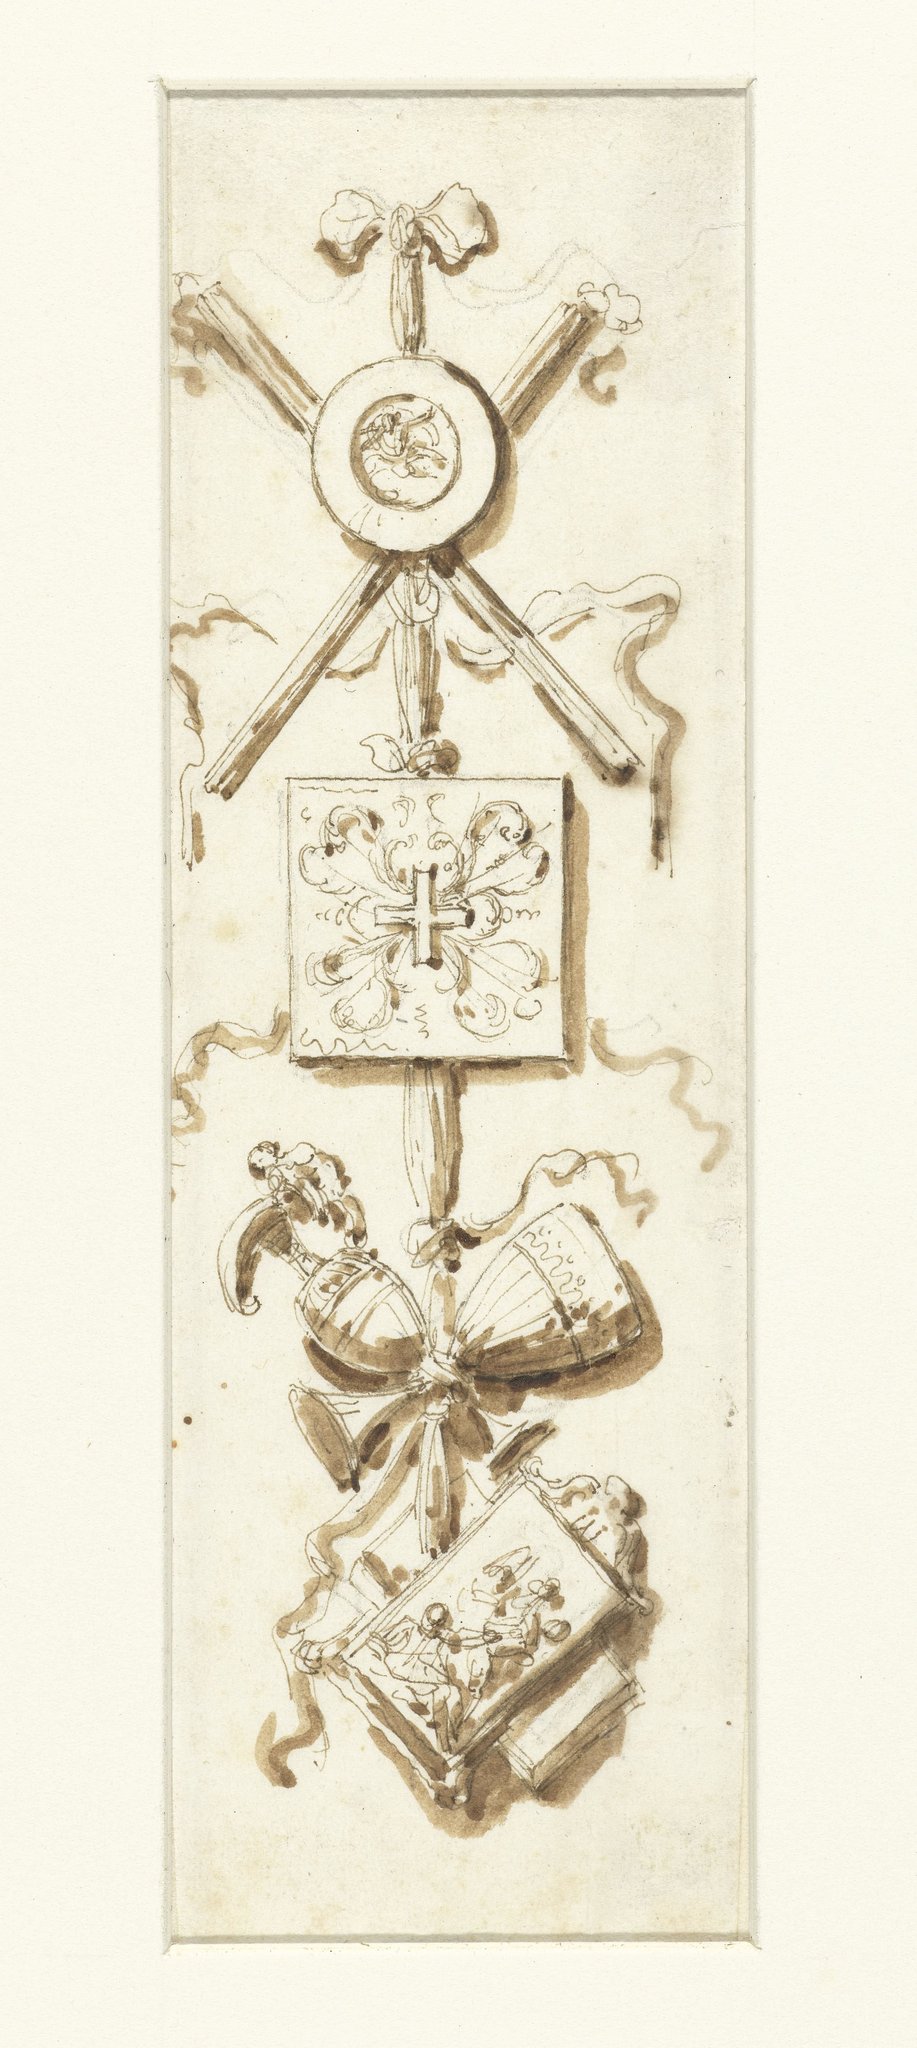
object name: drawing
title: Wierookvaasje met adelaarskop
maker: etienne de lavallée-poussin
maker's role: draughtsman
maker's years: 1733-1793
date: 1750-1793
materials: chalk, ink, paper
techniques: brush, pen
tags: ornament derived from objects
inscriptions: collector's mark, verso, lower centre: Lugt 2228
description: Wierookvaasje, toelopend in een adelaarskop en met een engelfiguur als handvat.